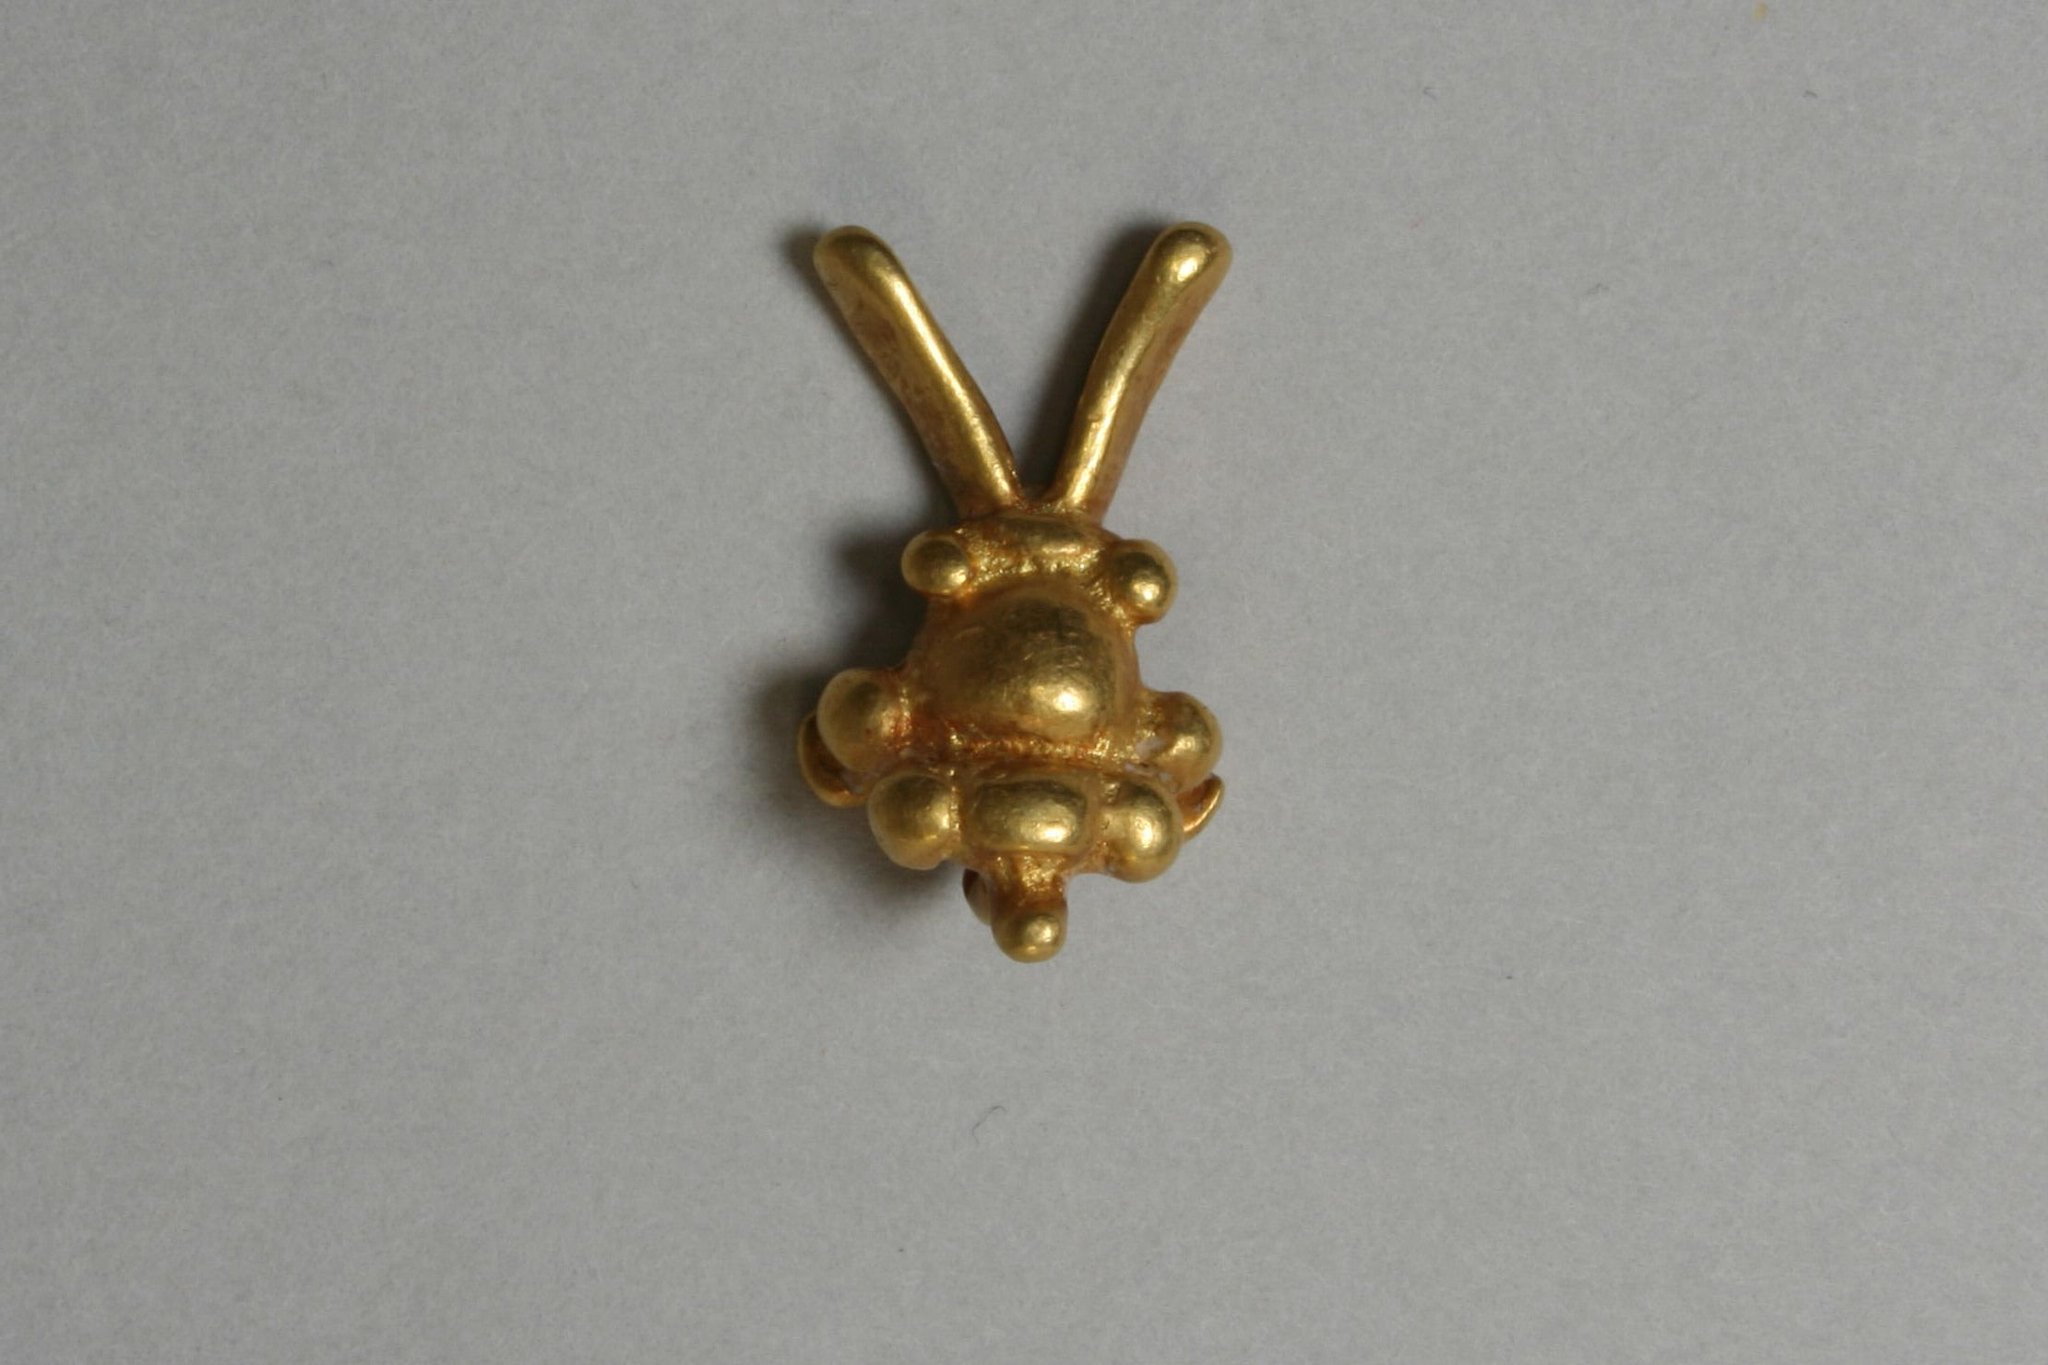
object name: ornament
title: Insect Ornament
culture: calima or yotoco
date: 1-700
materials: gold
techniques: casting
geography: colombia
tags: insects